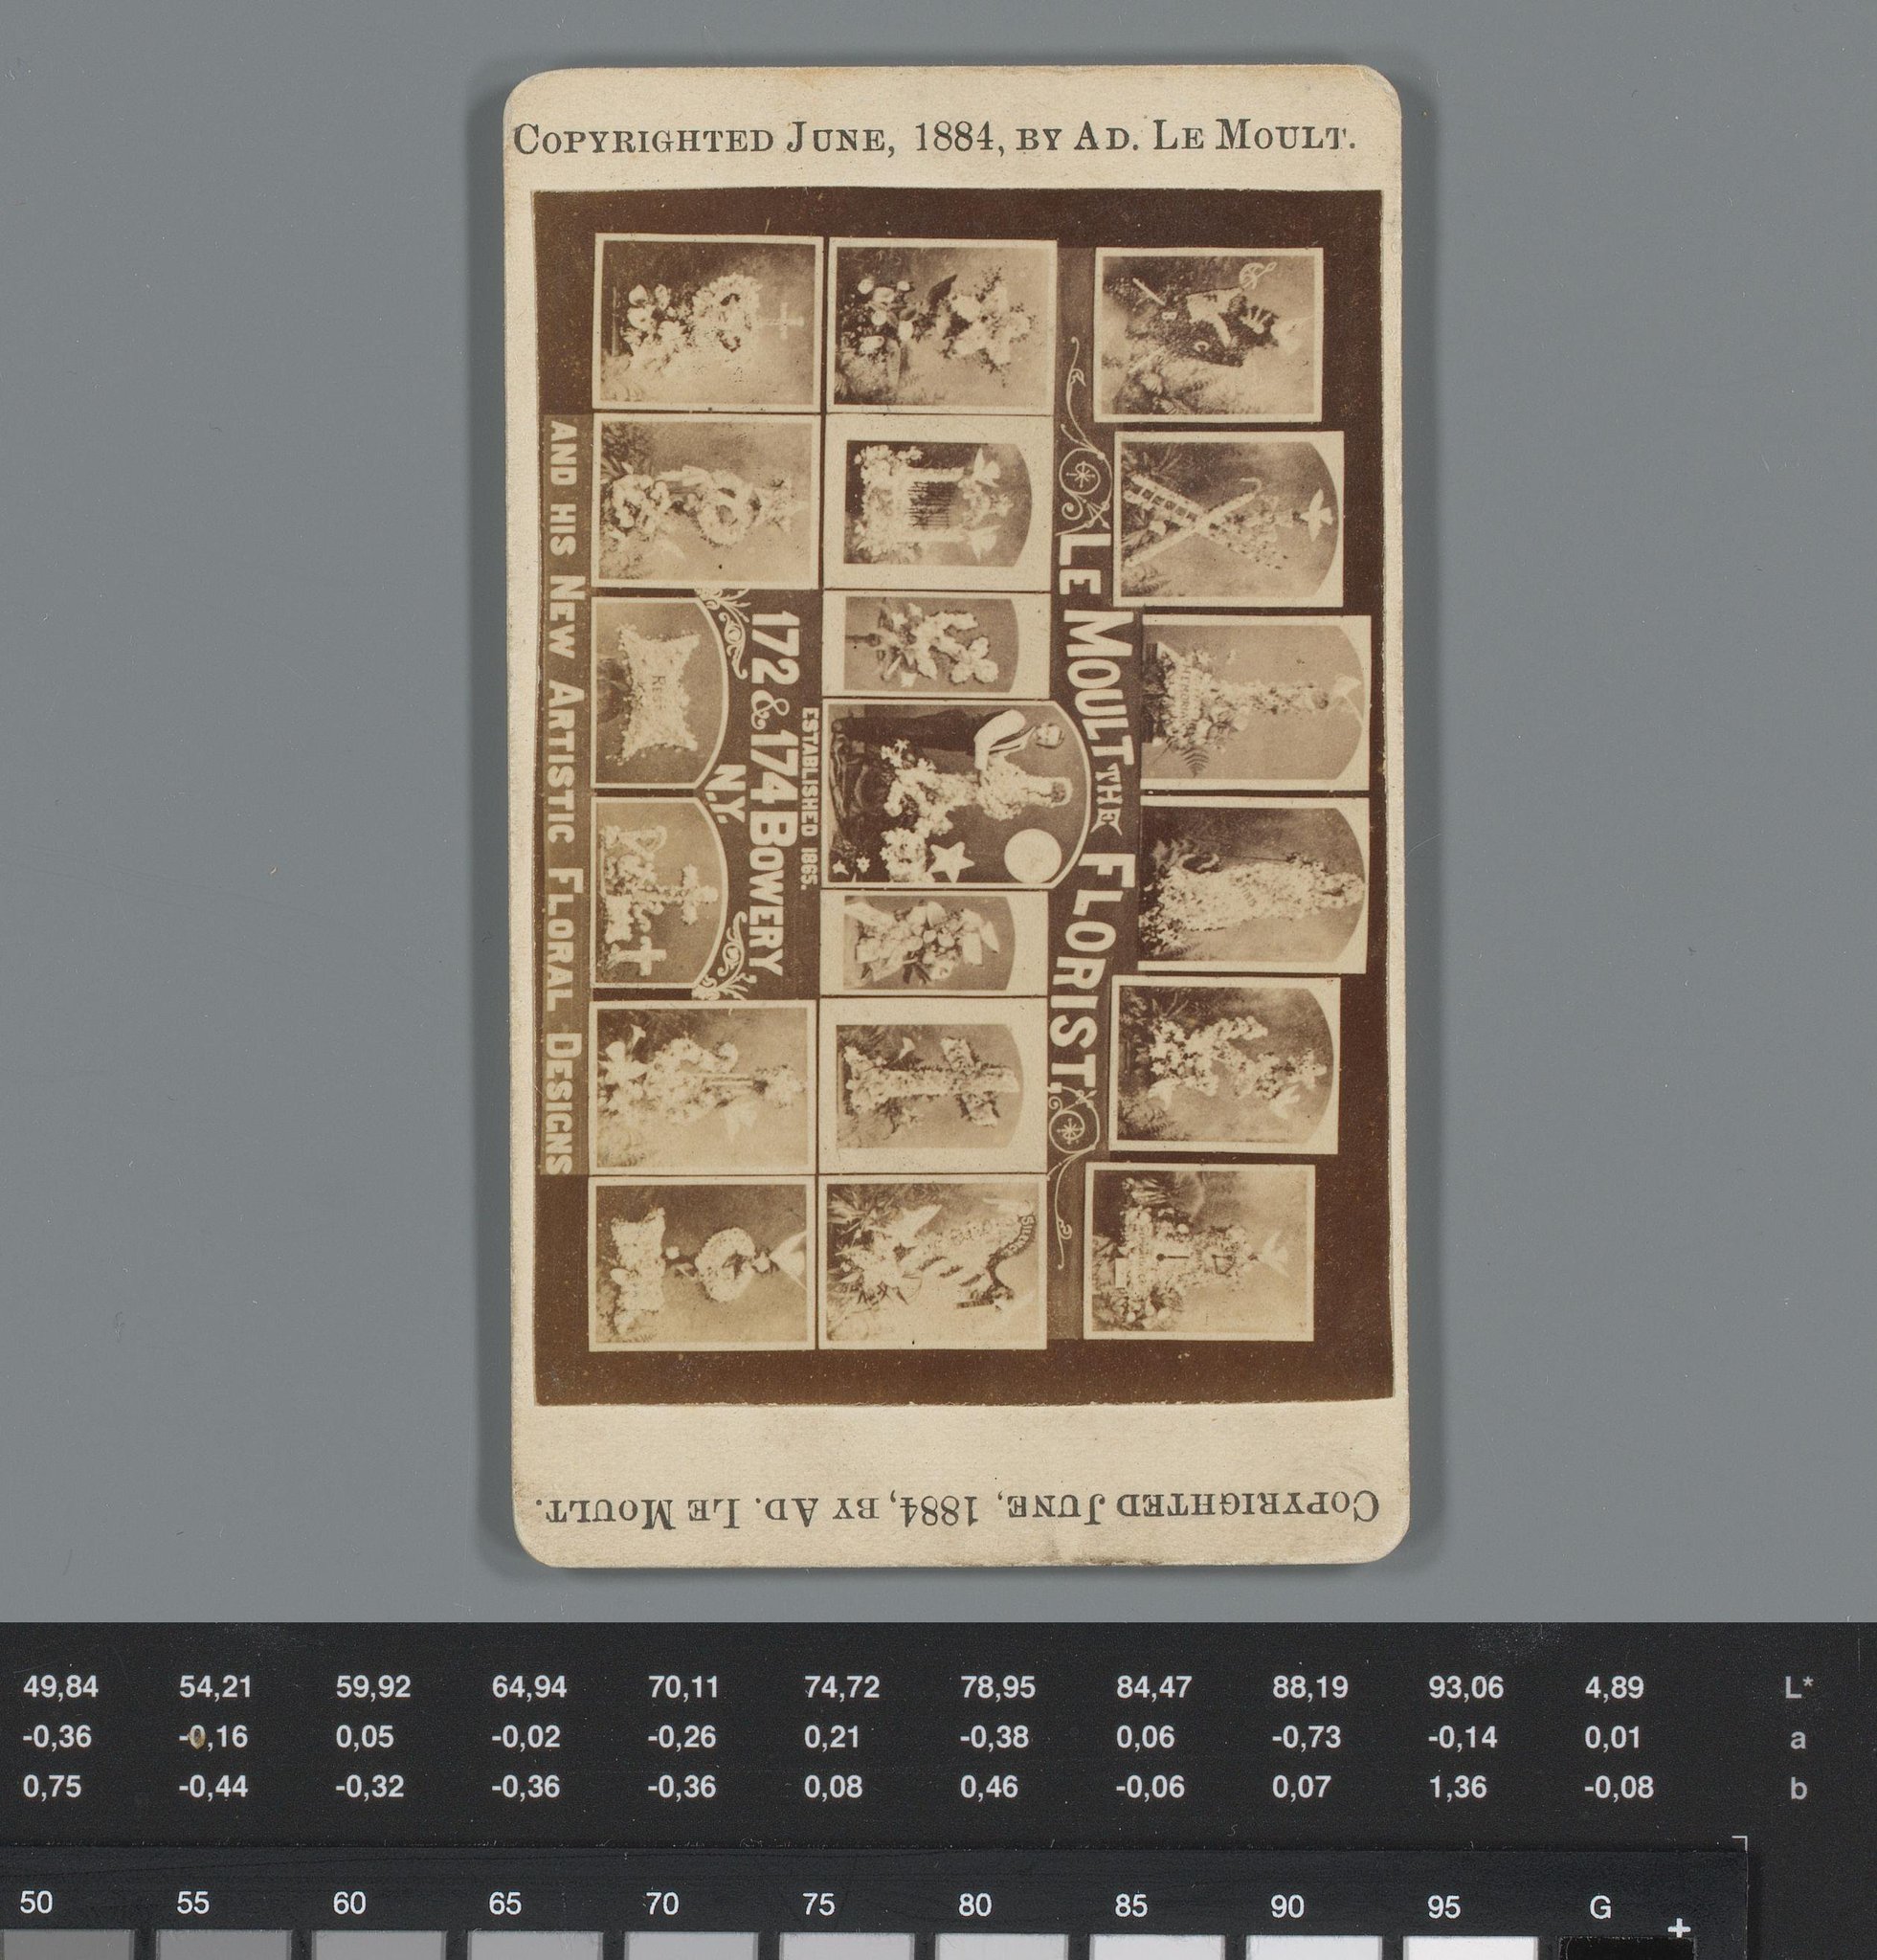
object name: carte de visite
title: Reclame voor bloemist Le Moult te New York met collage van negentien bloemstukken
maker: Anonymous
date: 1850-1915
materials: cardboard, photographic support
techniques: albumen print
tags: cut flowers; nosegay, bunch of flowers, advertising, arranging flowers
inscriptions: inscription: ‘(...) LE MOULT, The Florist. (...) New York.’